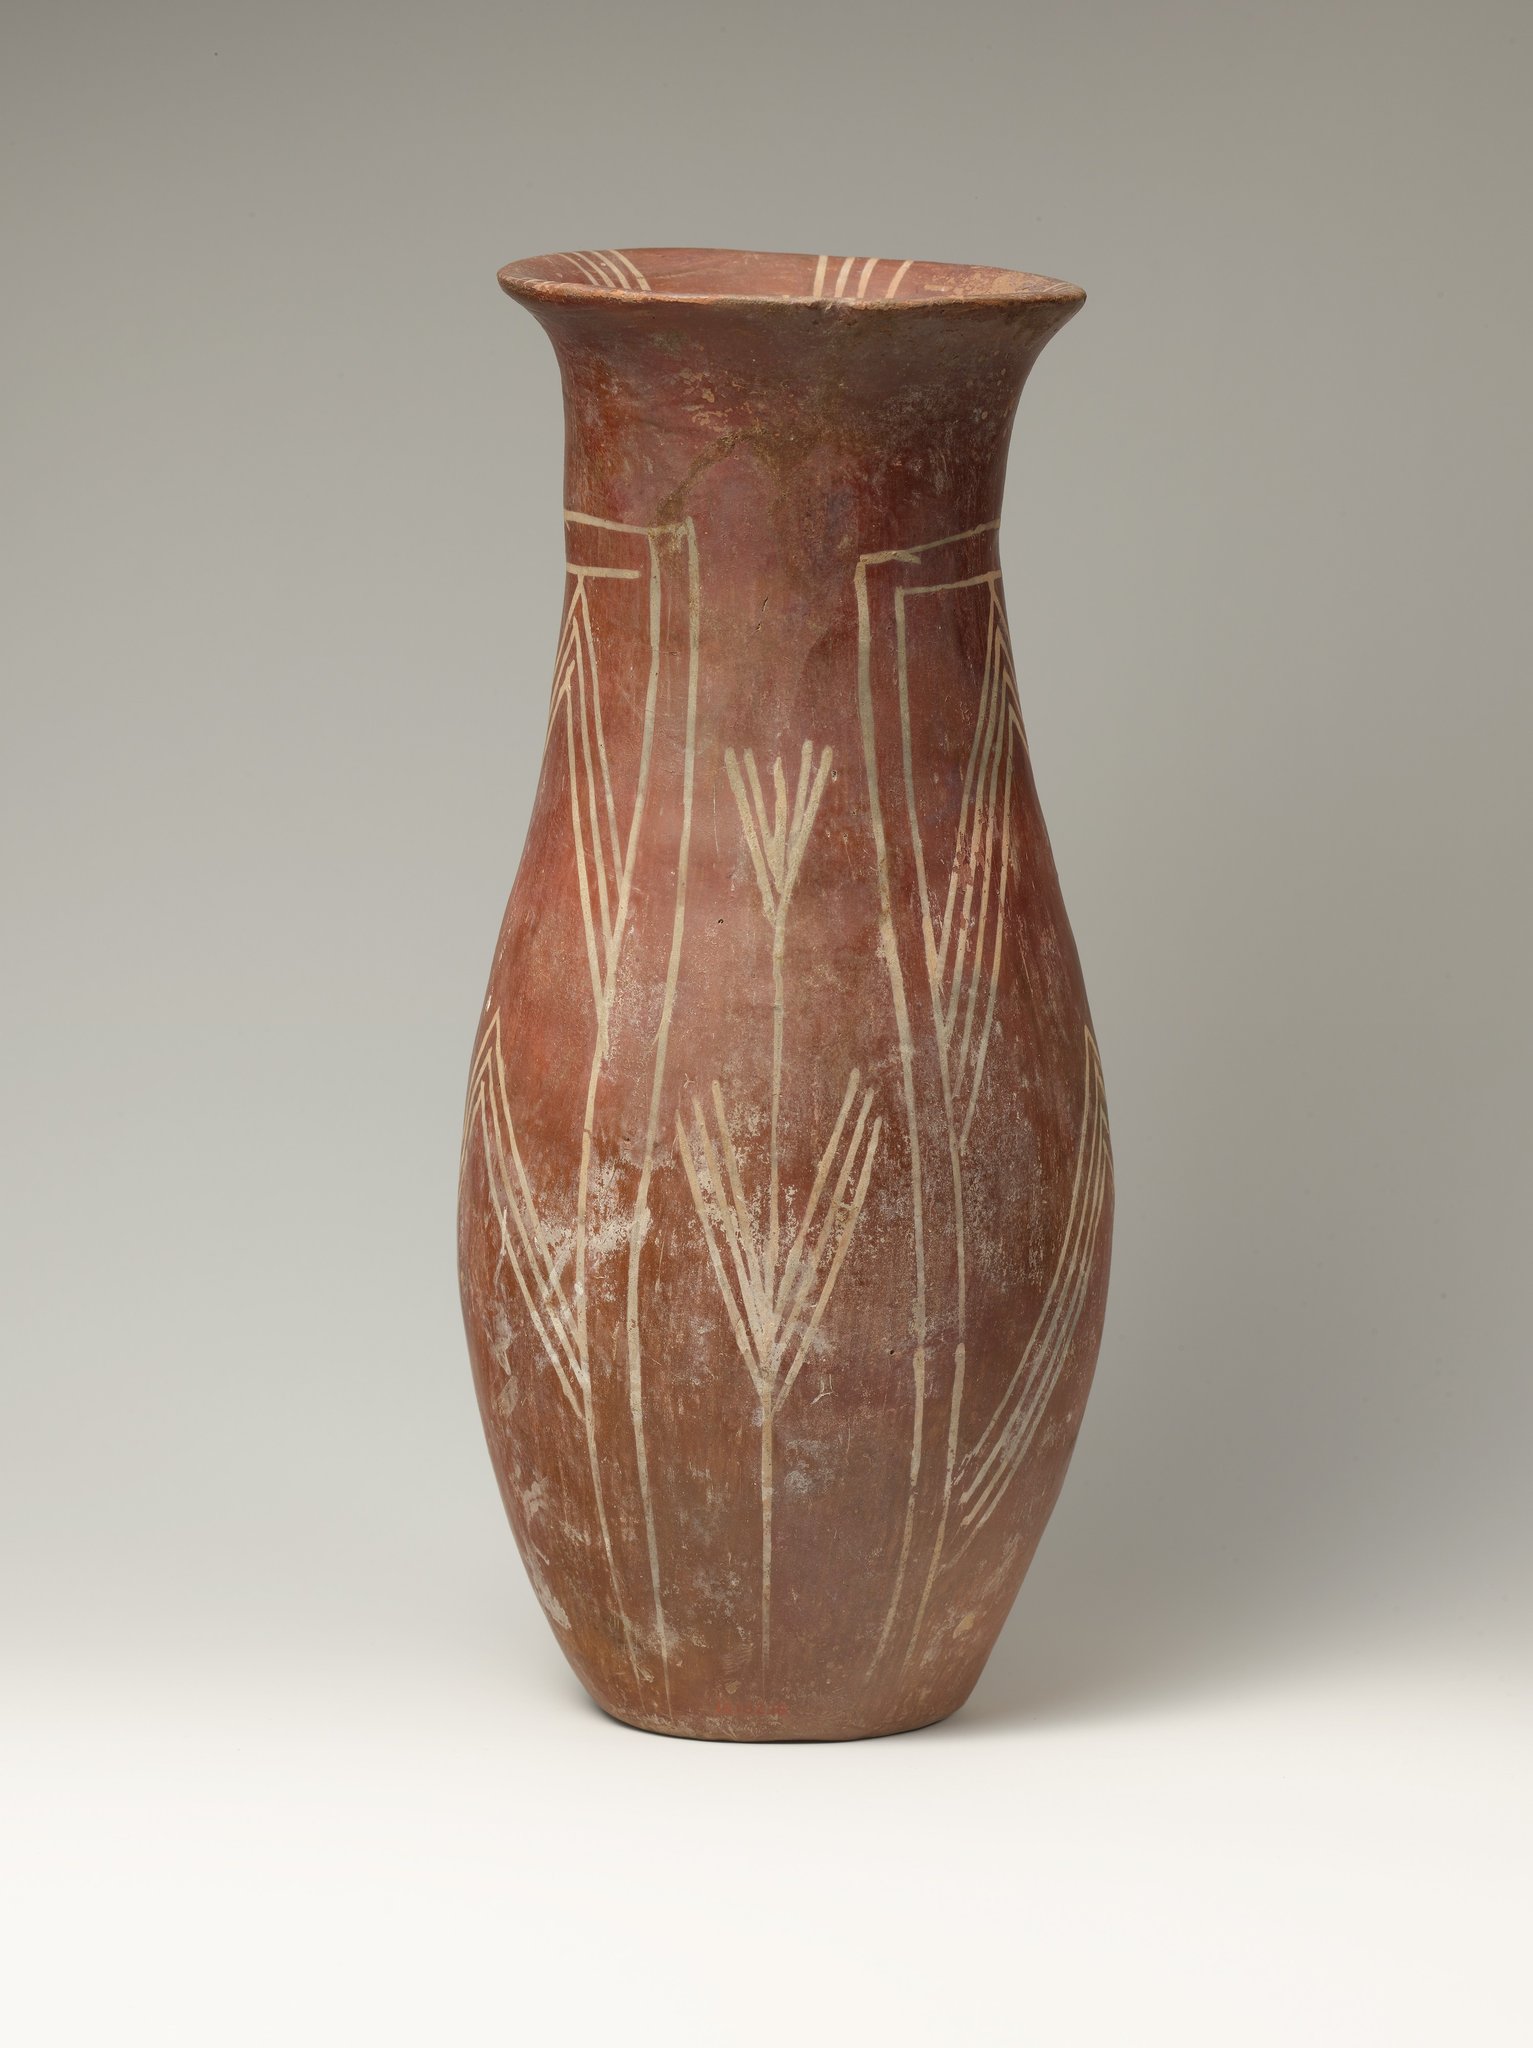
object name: vase, white cross lined ware, plant design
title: White cross-lined ware vase with plant designs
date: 3900-3700 BCE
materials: paint, pottery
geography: egypt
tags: plants